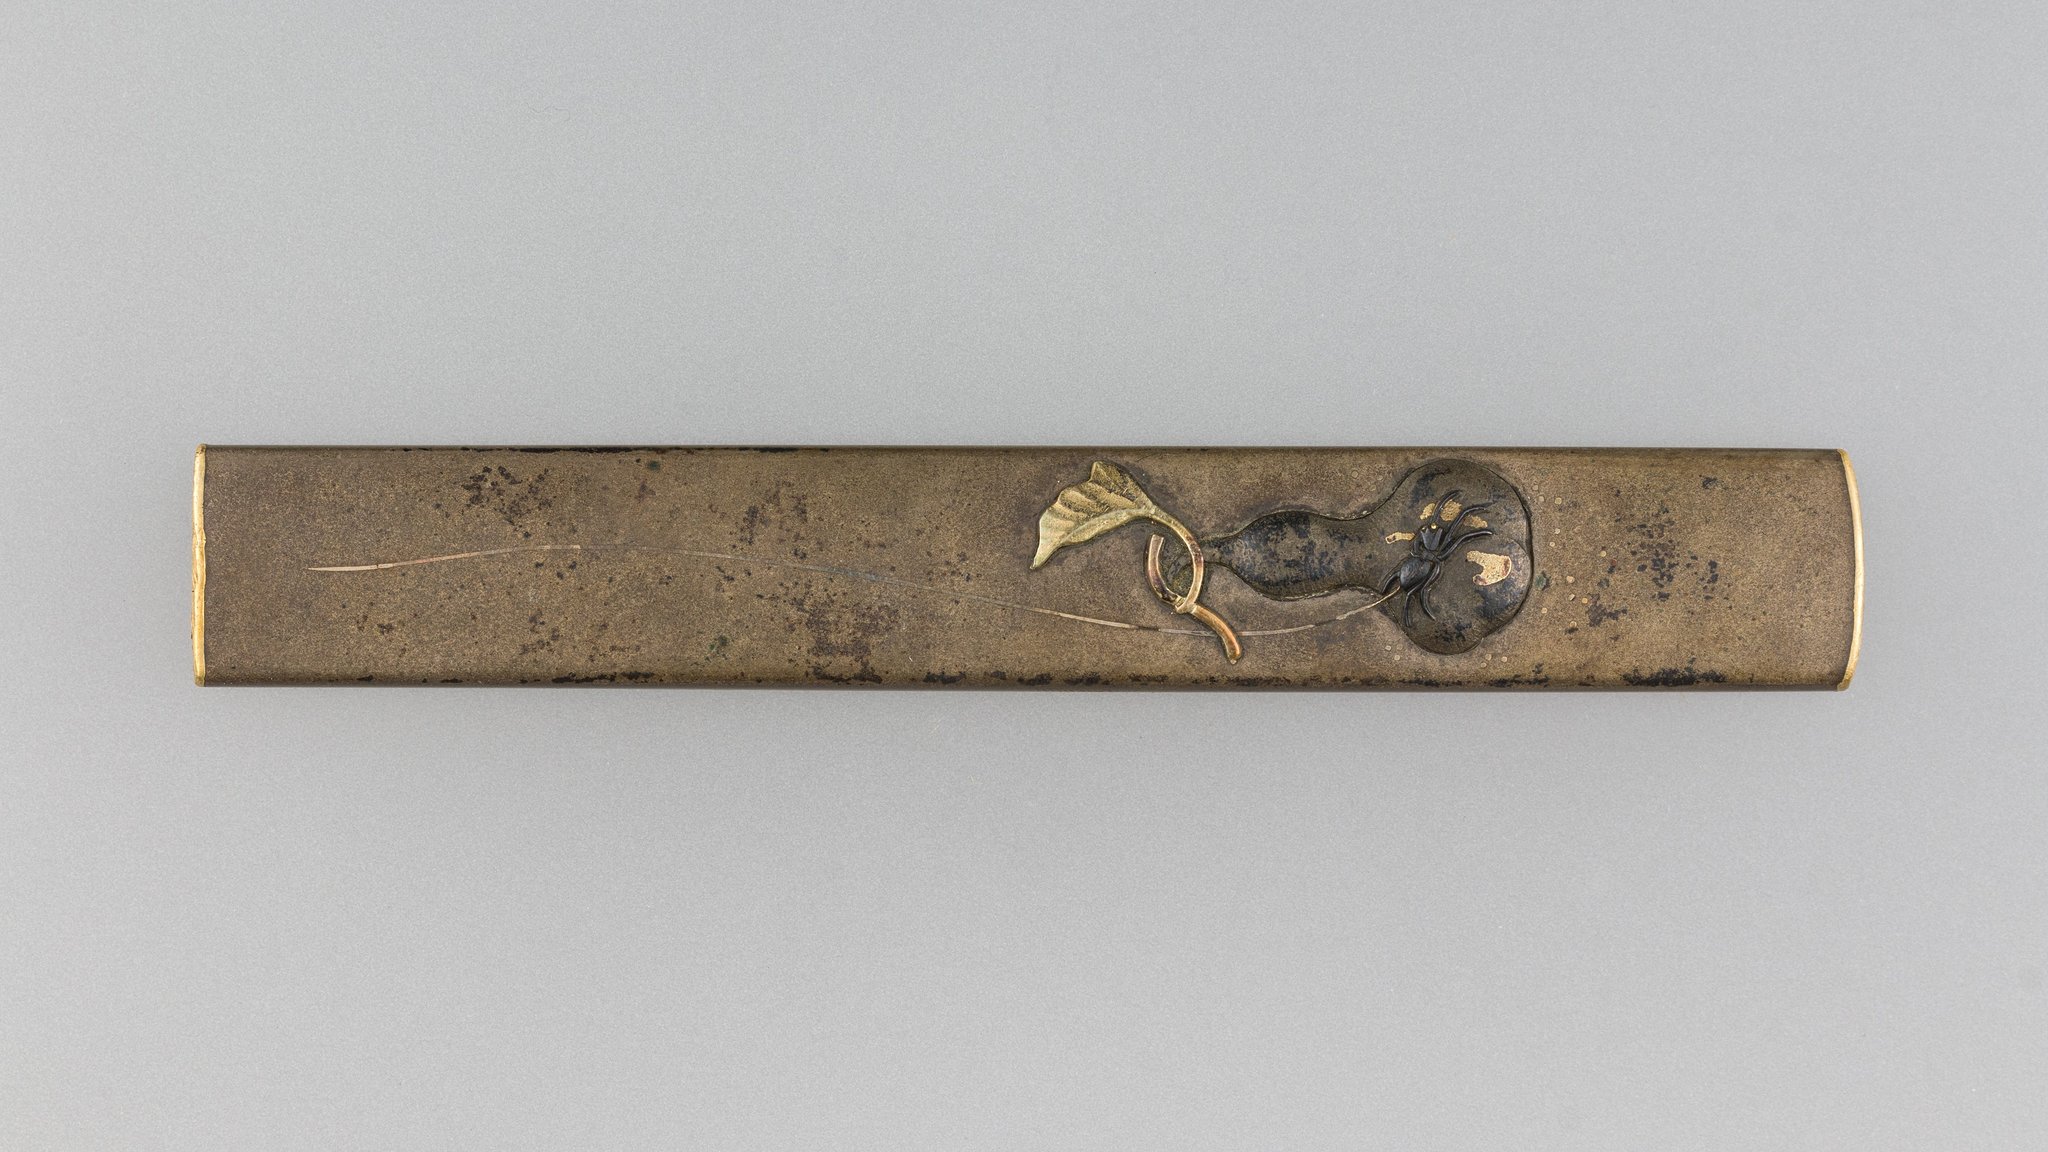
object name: knife handle kozuka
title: Knife Handle (Kozuka)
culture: japanese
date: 1634-1666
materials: gold alloy, silver alloy, gold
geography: japan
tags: gourds